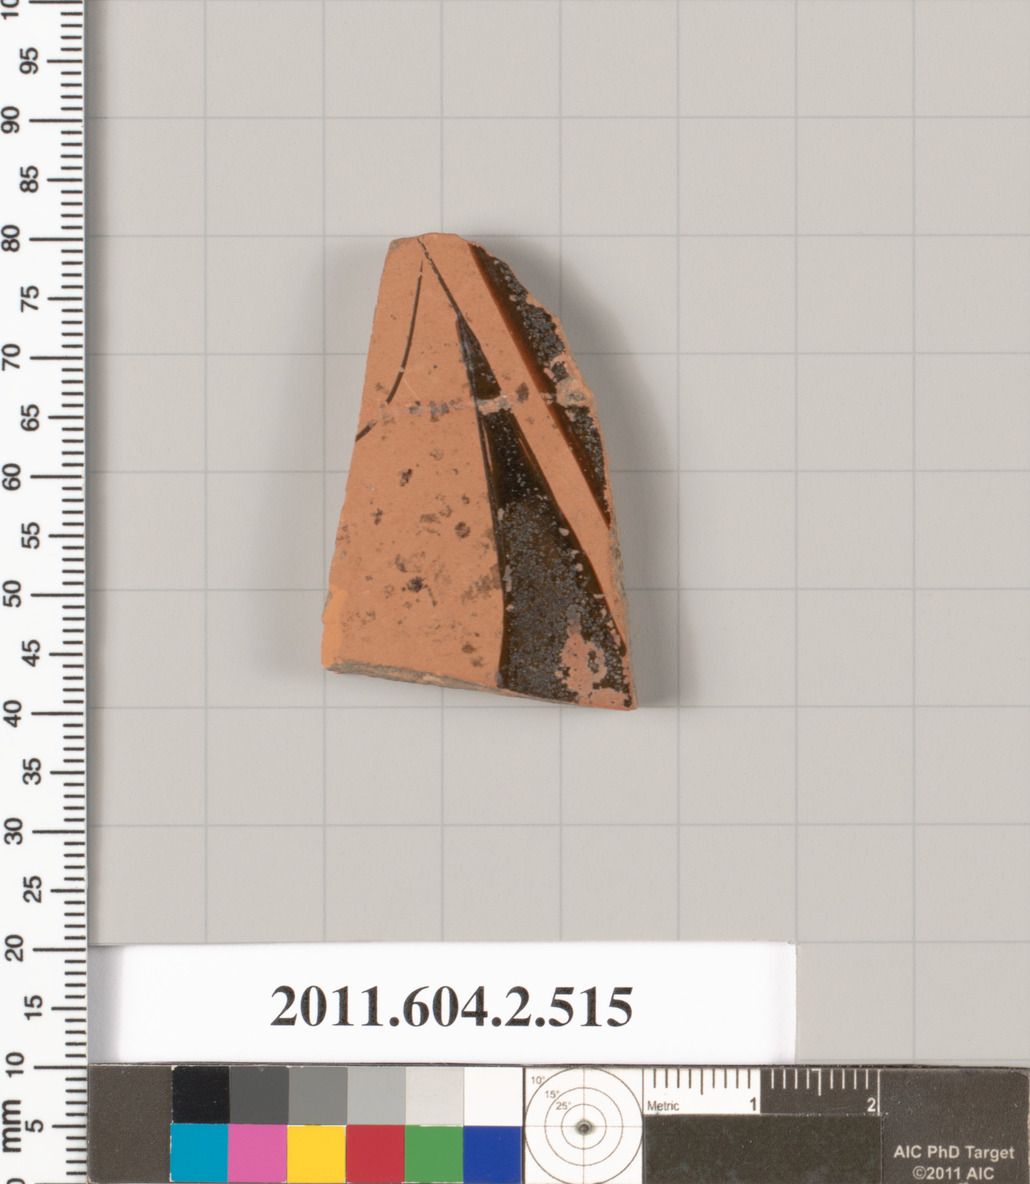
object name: column krater fragment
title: Terracotta fragment of a column-krater (bowl for mixing wine and water)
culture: greek, attic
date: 460-440 BCE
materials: terracotta